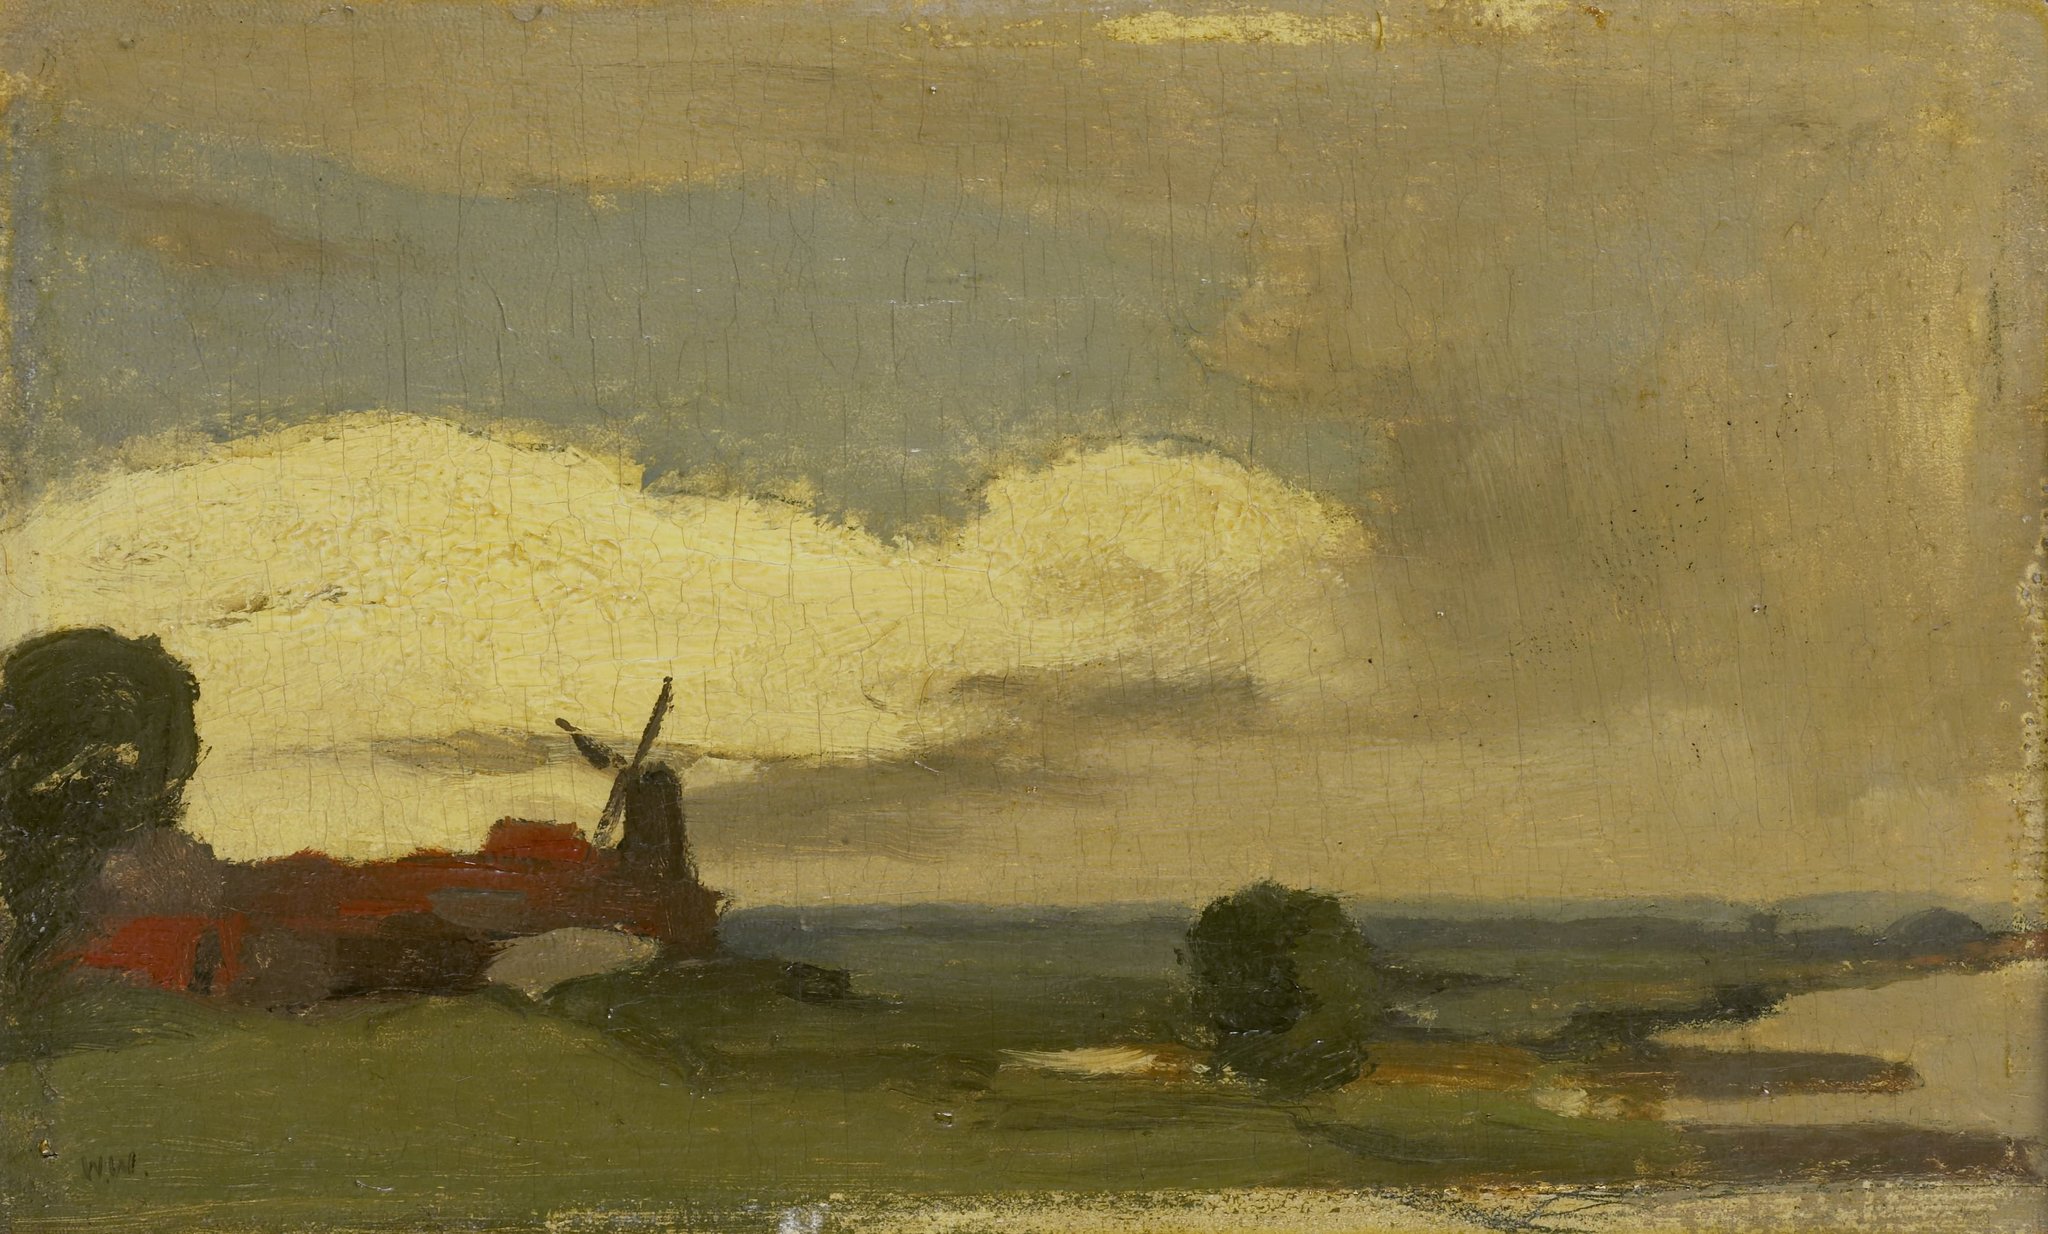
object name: painting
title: Landschap met de molen van Wijk bij Duurstede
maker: willem witsen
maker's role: draughtsman, painter, print maker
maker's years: 1860-1923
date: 1885-1923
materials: oil, panel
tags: watermill in landscape, wijk bij duurstede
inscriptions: signature: ‘W.W.’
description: Landschap met de molen van Wijk bij Duurstede, rechts een rivier.